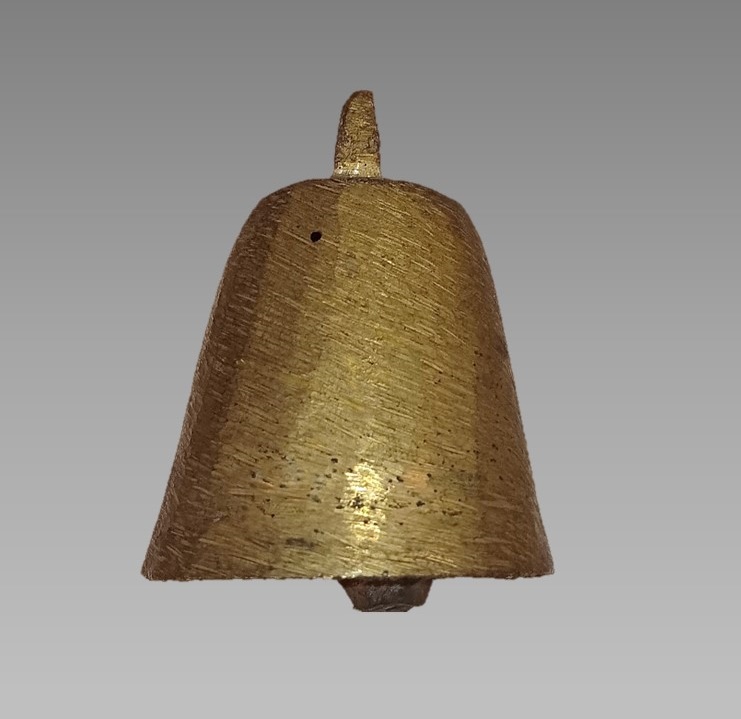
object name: zanguleh zangula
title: Zanguleh (zangula)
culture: iranian or persian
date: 1850-1889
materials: metal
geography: iran